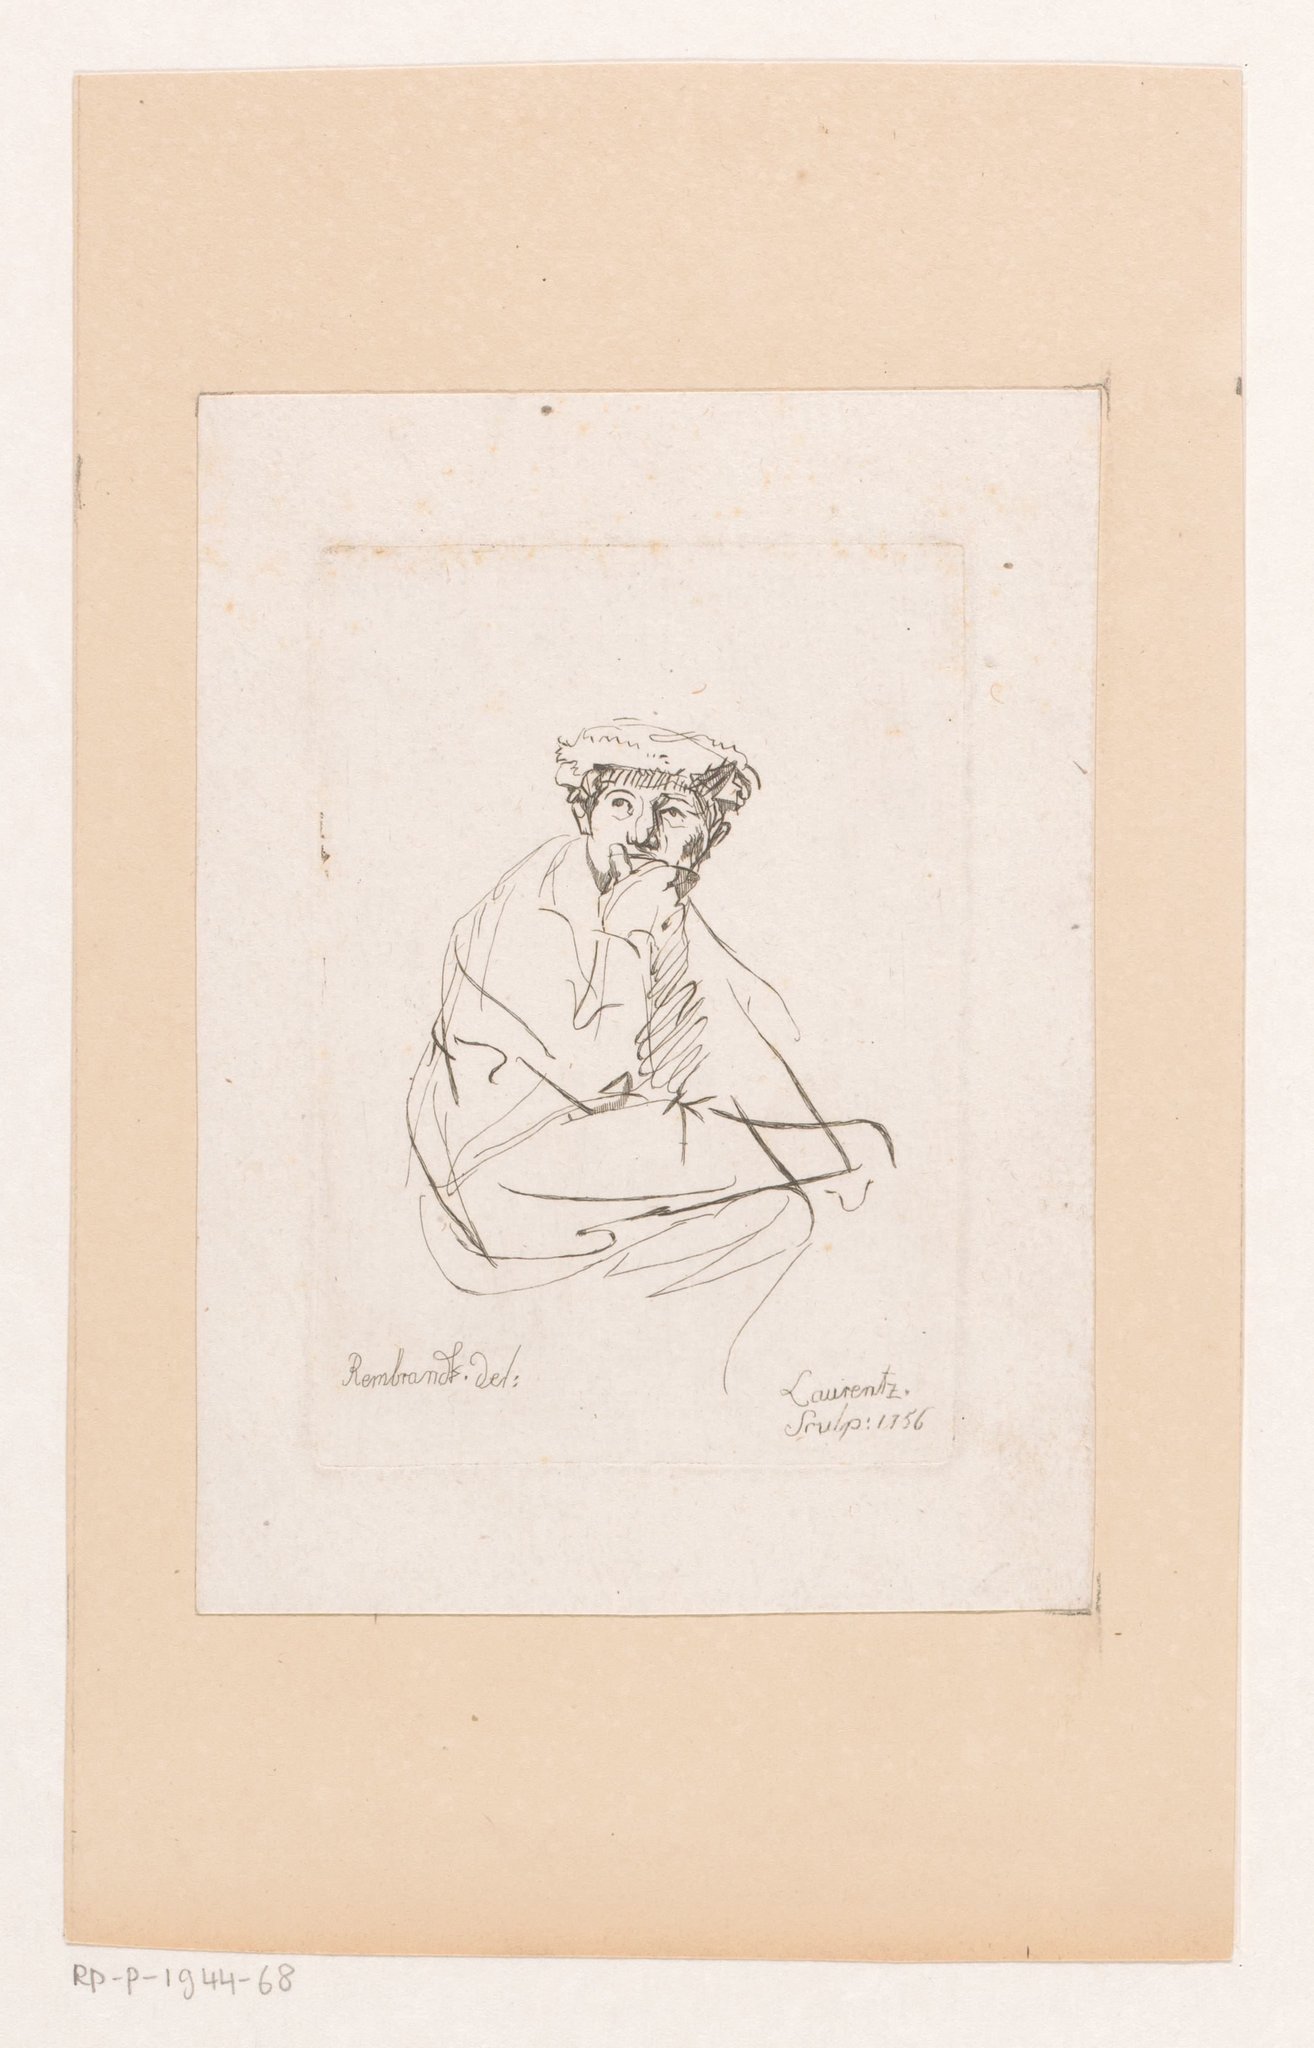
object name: print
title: Portret van een onbekende man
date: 1756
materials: paper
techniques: etching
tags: anonymous historical person portrayed, leaning figure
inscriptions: collector's mark: Lugt 240, collector's mark: Lugt 2228